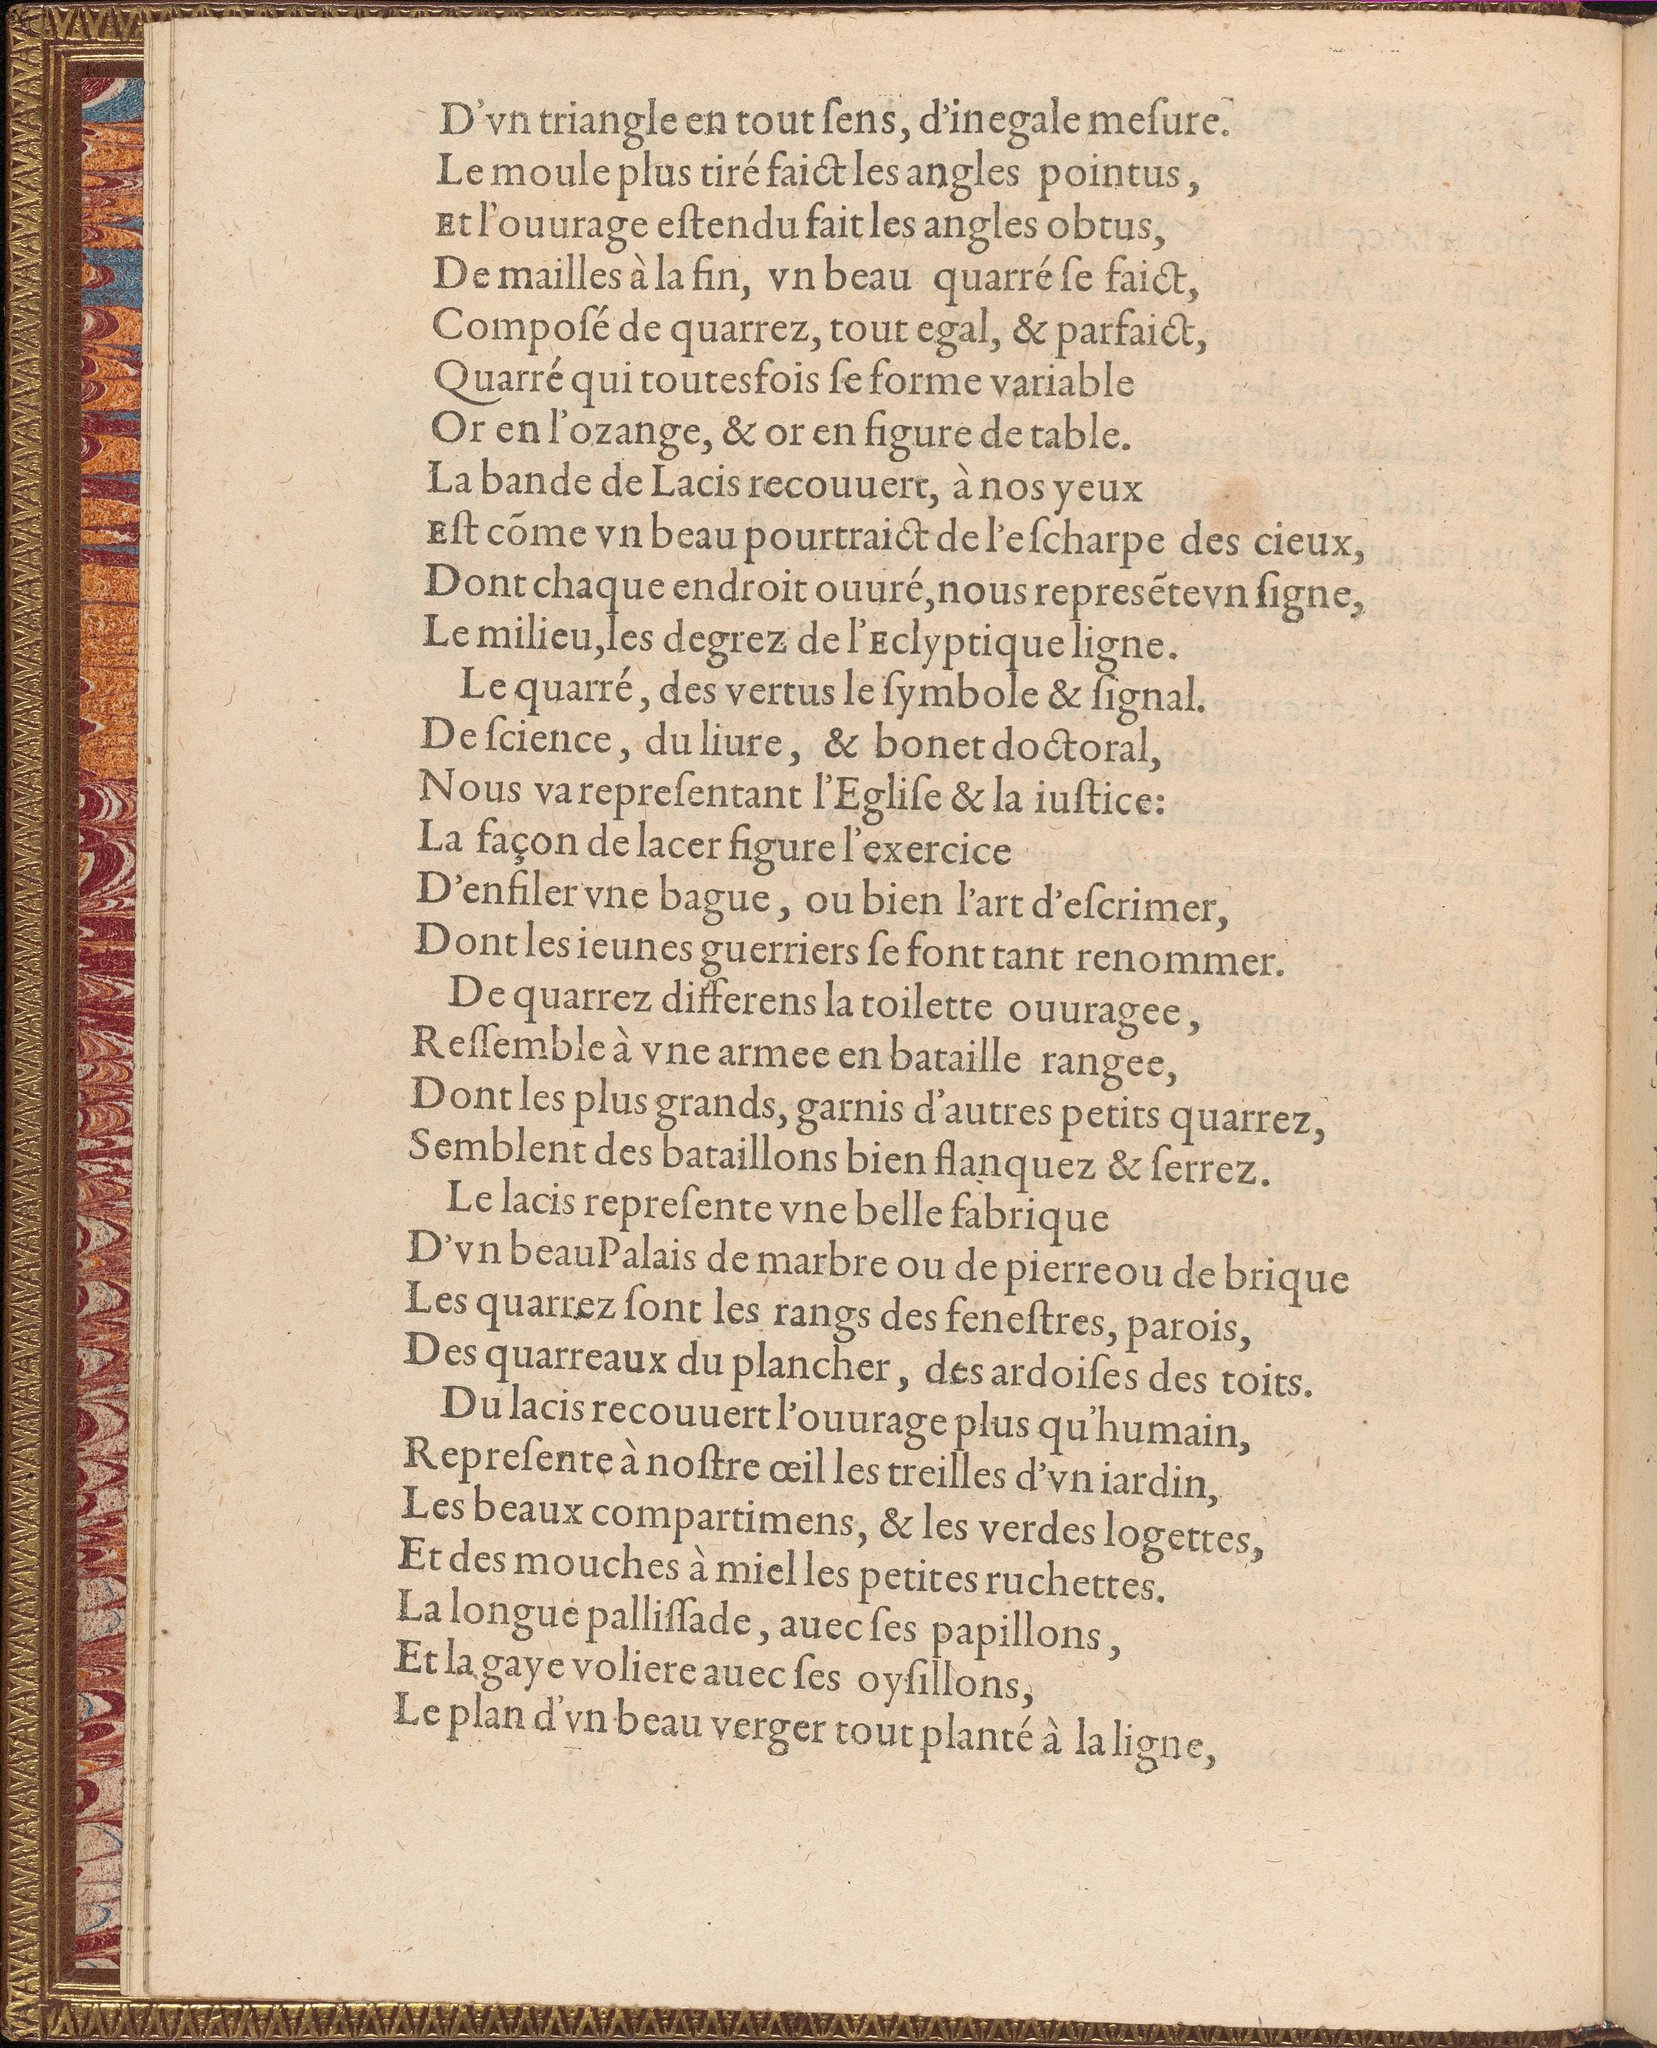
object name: book print ornament architecture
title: La Pratique de l'Aiguille, page 3 (verso)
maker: matthias mignerak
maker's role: author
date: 1605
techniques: woodcut